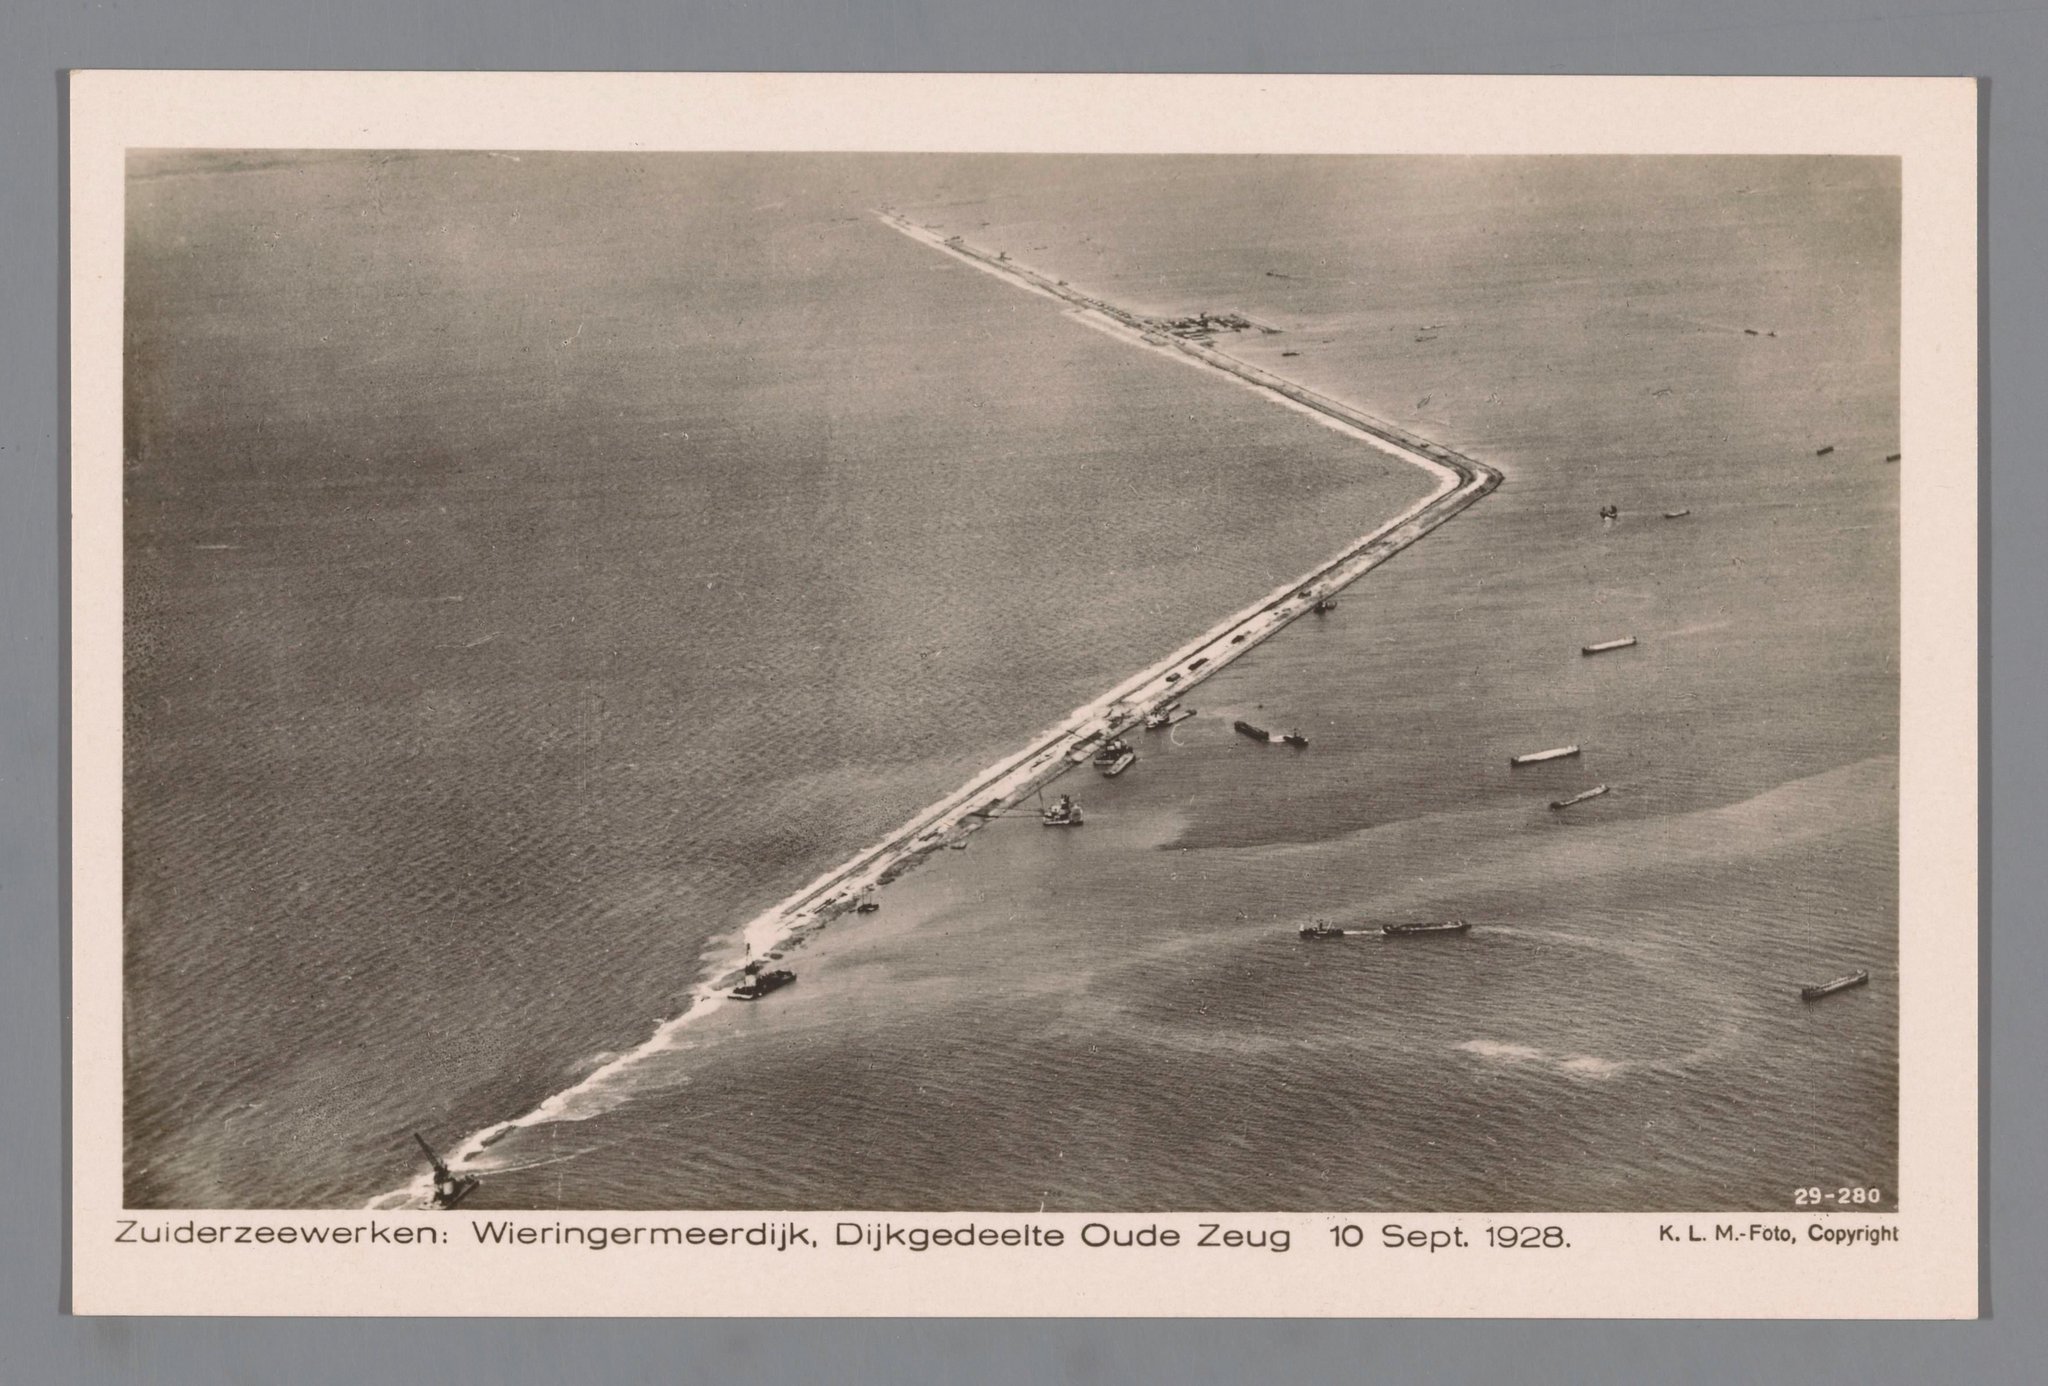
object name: photograph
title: Zuiderzeewerken: Wieringermeer, Dijkgedeelte Oude Zeug 10 sept. 1928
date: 1928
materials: cardboard, photographic support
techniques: gelatin silver print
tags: dikes, levee, zuiderzee